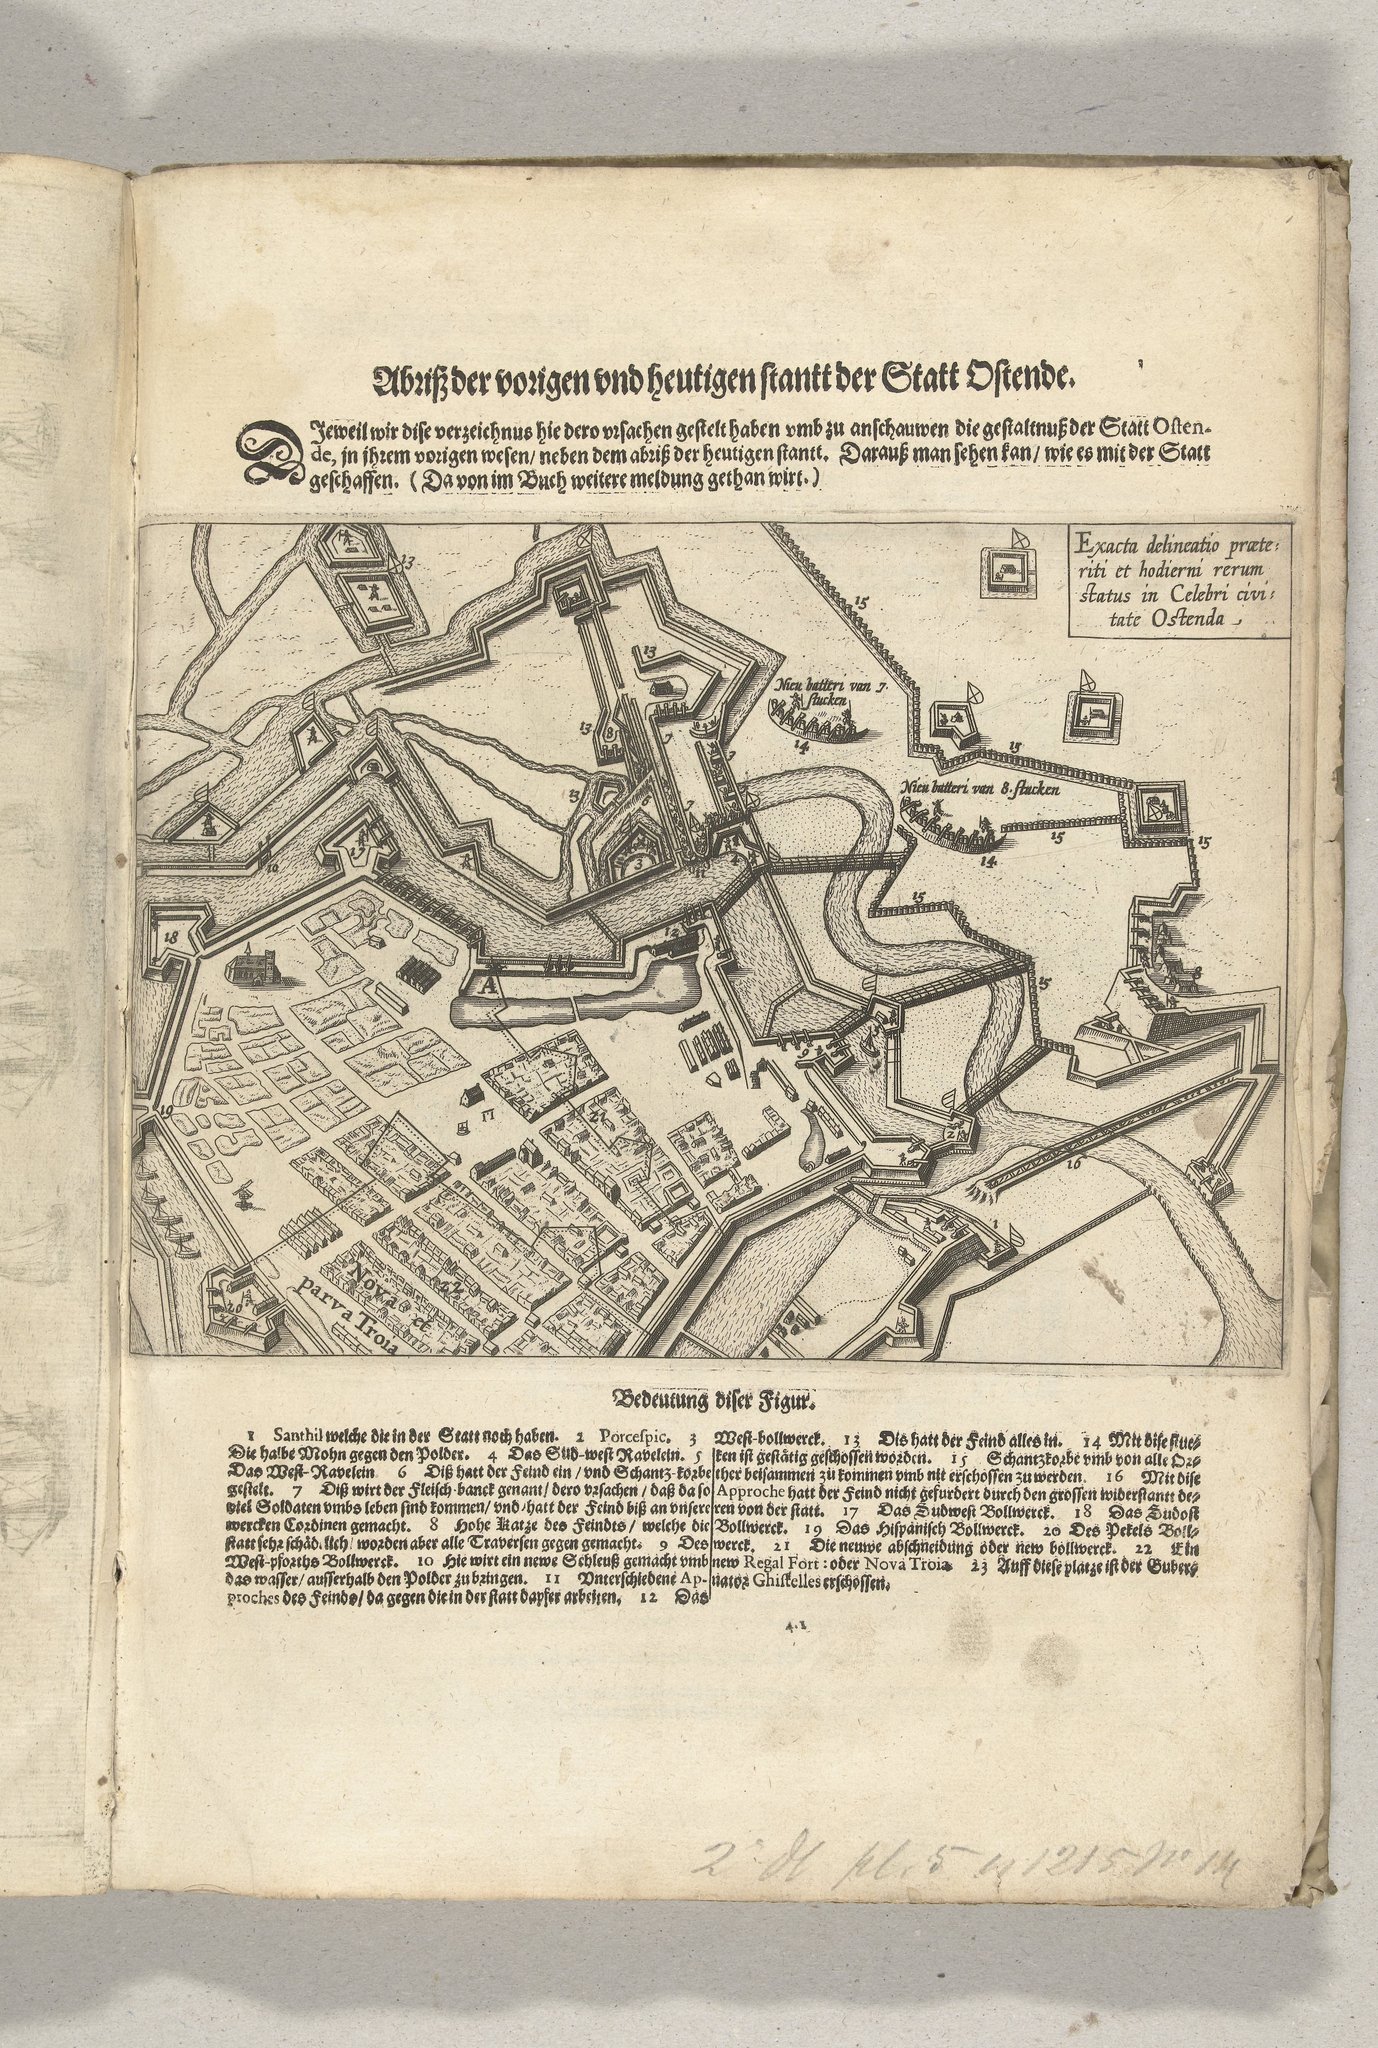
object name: print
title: Abriß der vorigen und heutigen stantt der Statt Ostende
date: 1604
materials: paper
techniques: etching, letterpress printing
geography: low countries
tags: siege, position war, fortifications, military engineering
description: Onderdeel van illustraties in: Belaegerung der Statt Ostende : Journal: Tagregister... aller gedenckwurdigsten Sachen... so inner und ausserhalb... sich zugetragen... von 5 July 1601. biss auff diese.. Herbstmisse Anno 1604... auss der Niderlendischen in die Hochteutsche Sprach transferirt, Und mit: Journal. Ander theil uber die Belägerung der statt Ostende biss auf die Herbstmiss in Sept. 1604 bey gefugt Mappa der Statt Ostende neben dem abriss des Parvae und Novae Troiae, s.l., 1604, fol°, ill. Hierbij gevoegd enkele prenten voorzien van Duitse teksten, 1604 (z.n., z.p.). In het exemplaar in de collectie van de Rijksmuseum Research Library (326 F 10).